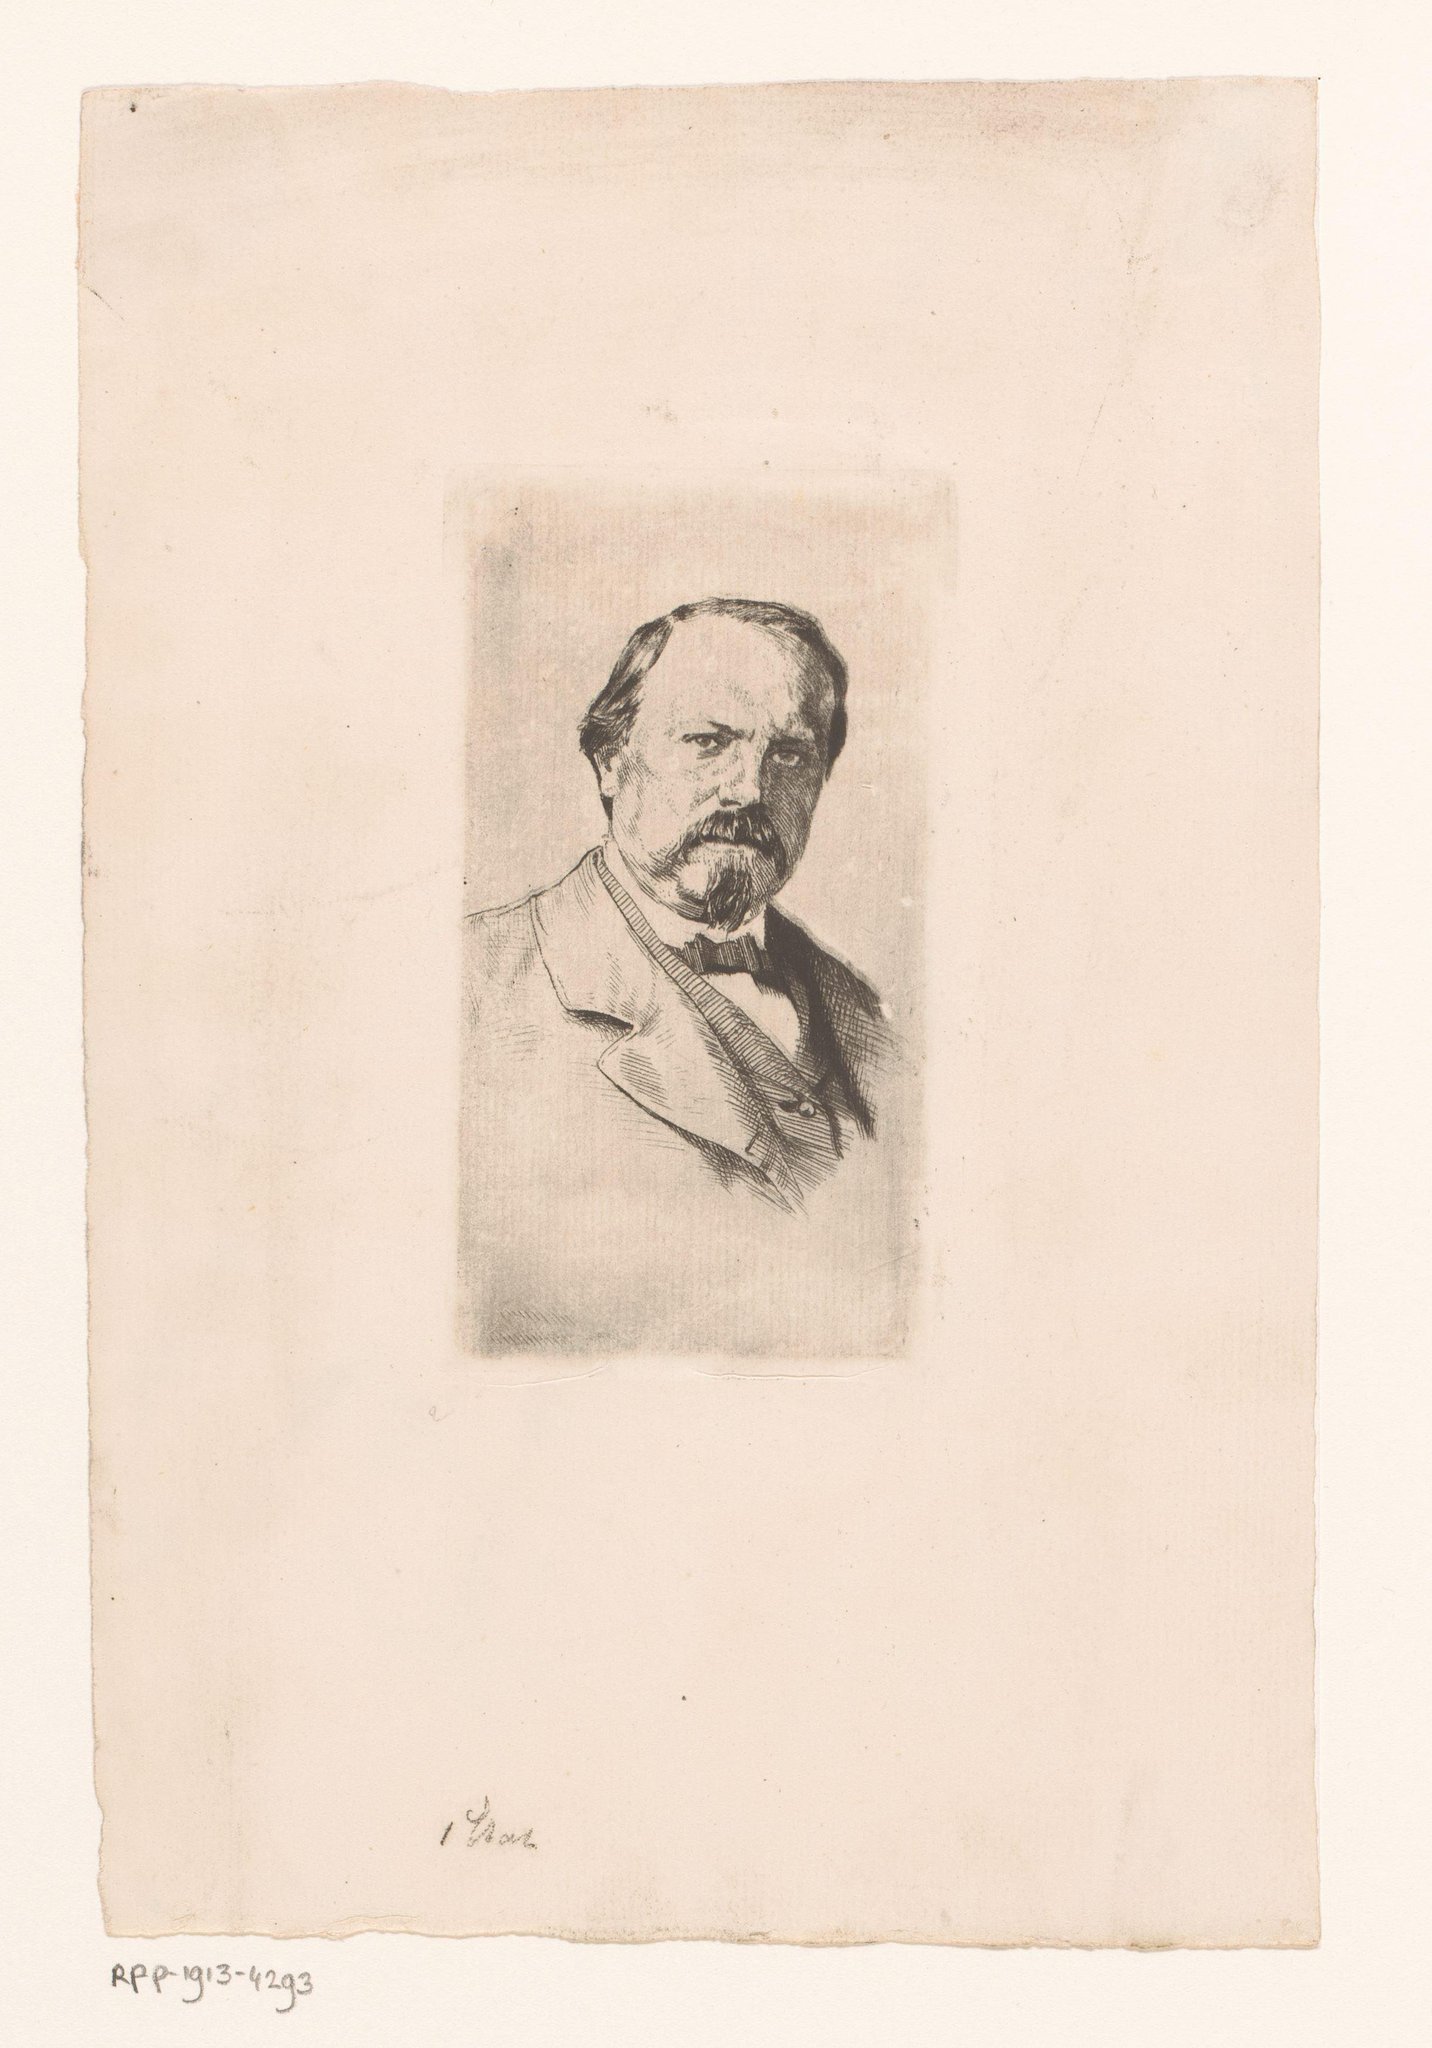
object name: print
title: Portret van Nicolas Defrêcheux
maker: adrien de witte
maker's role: print maker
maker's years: 1850-1935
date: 1877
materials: paper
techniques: etching, intaglio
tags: moustache, adult man, historical persons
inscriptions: collector's mark: Lugt 2228